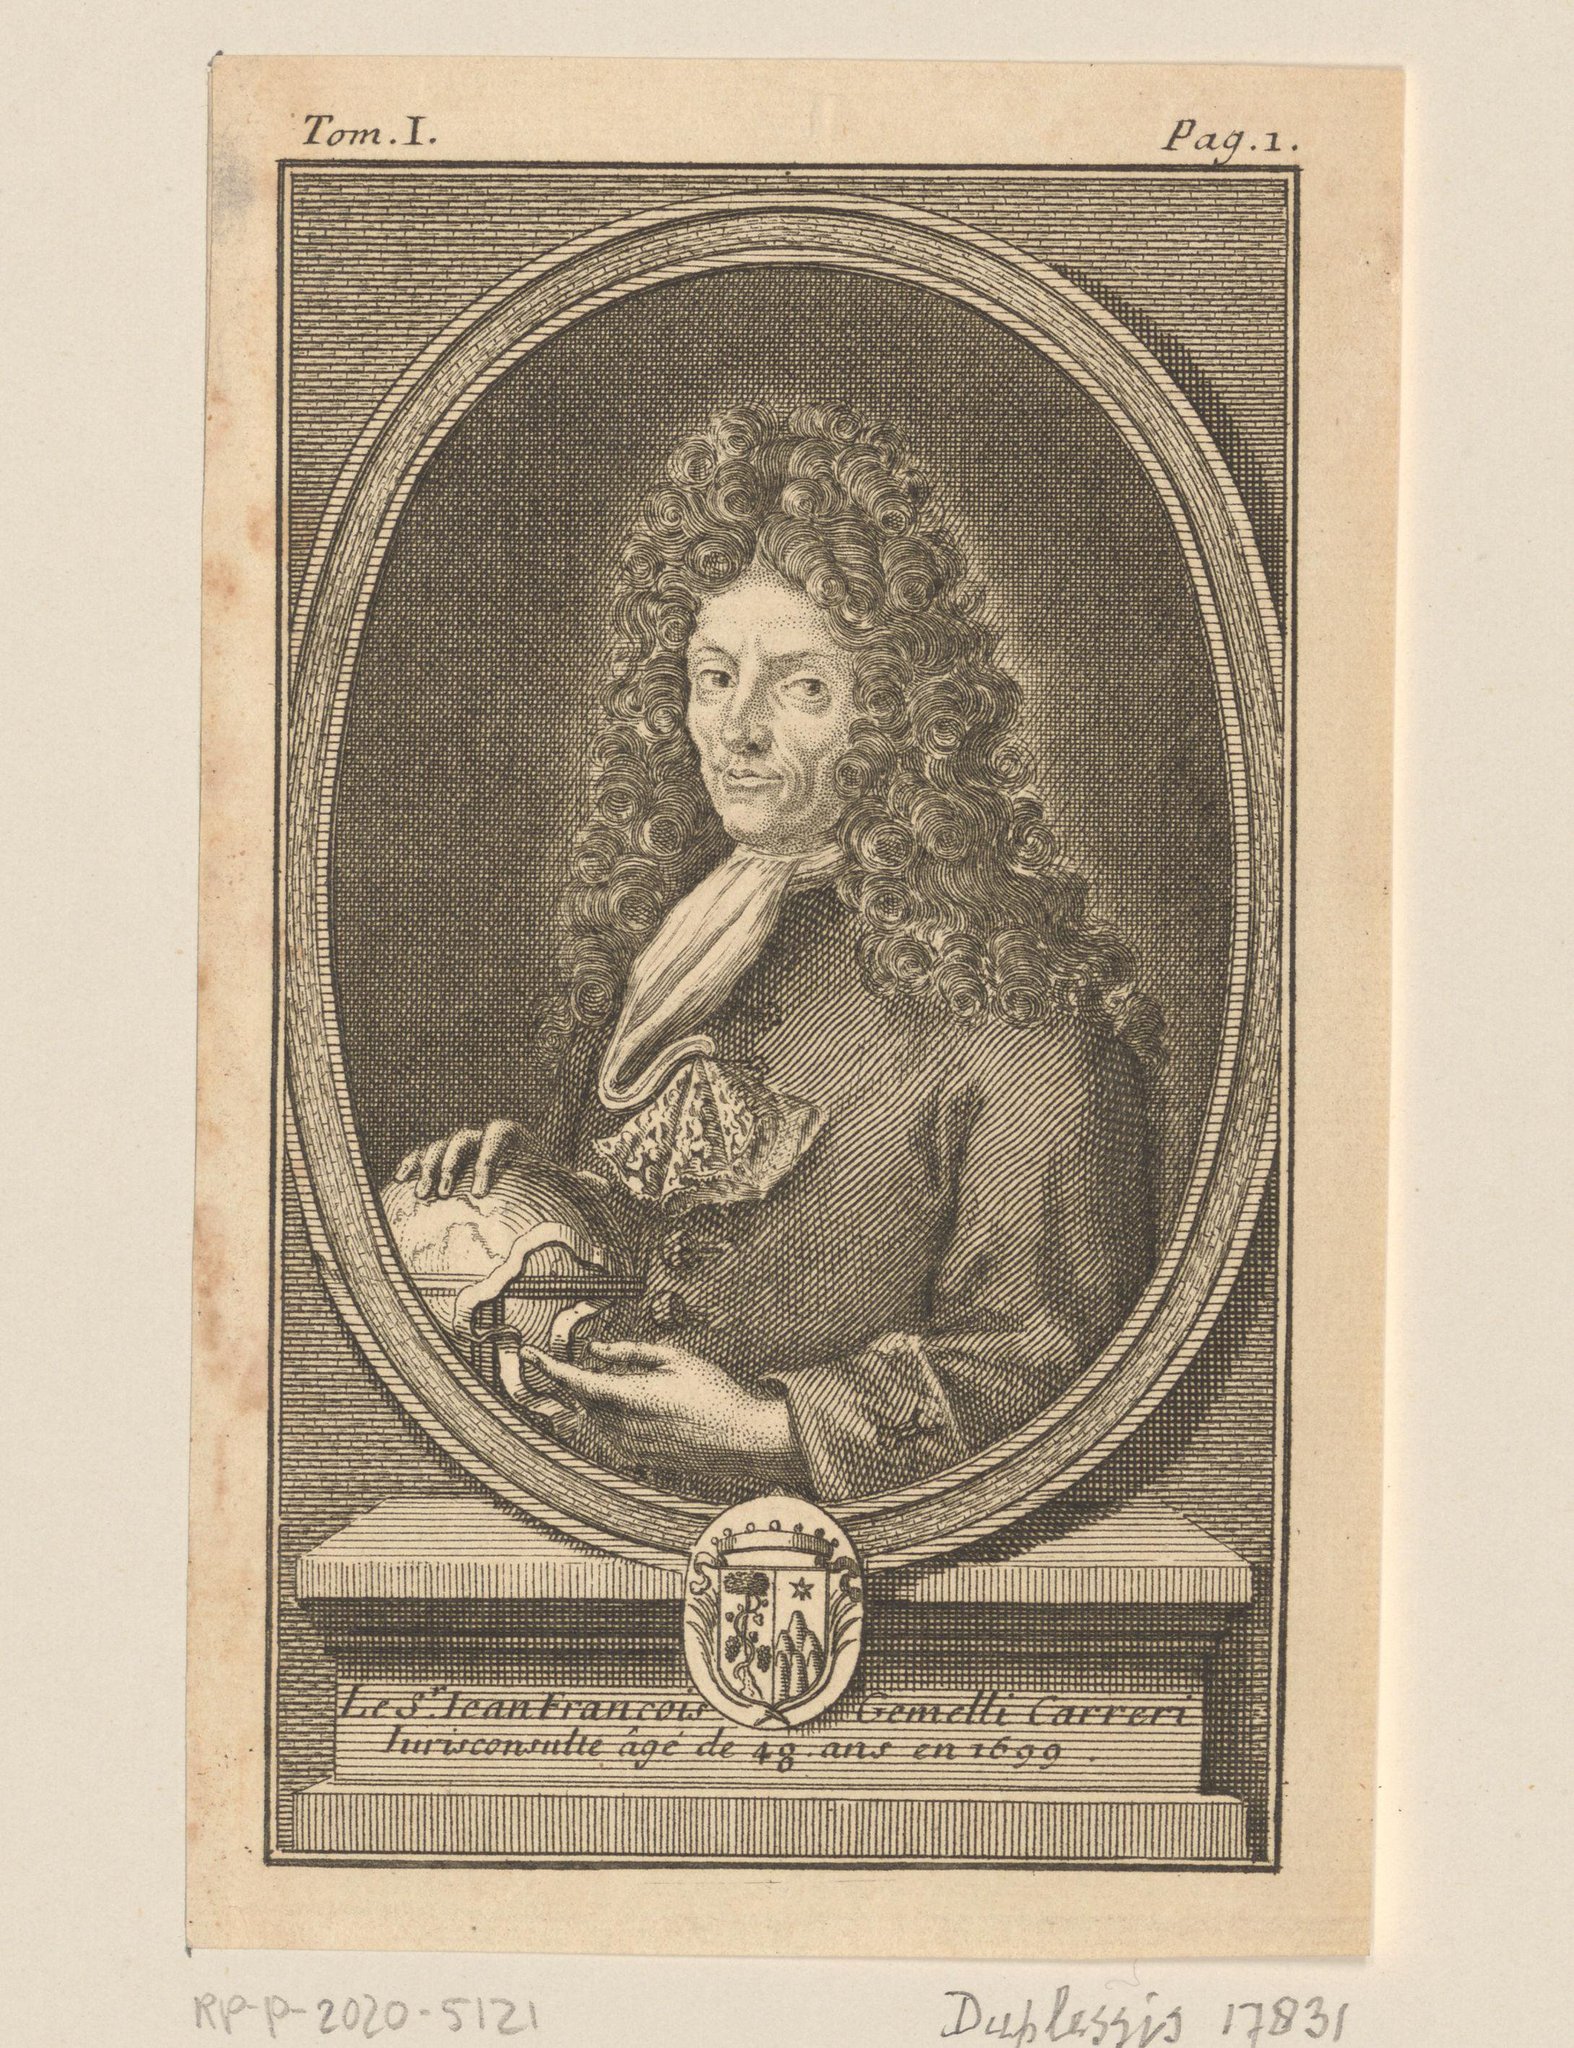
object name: print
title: Portret van Gemelli Careri op 48-jarige leeftijd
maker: Anonymous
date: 1699-1725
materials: paper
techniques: engraving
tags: naples, historical persons, lawyer, attorney at law